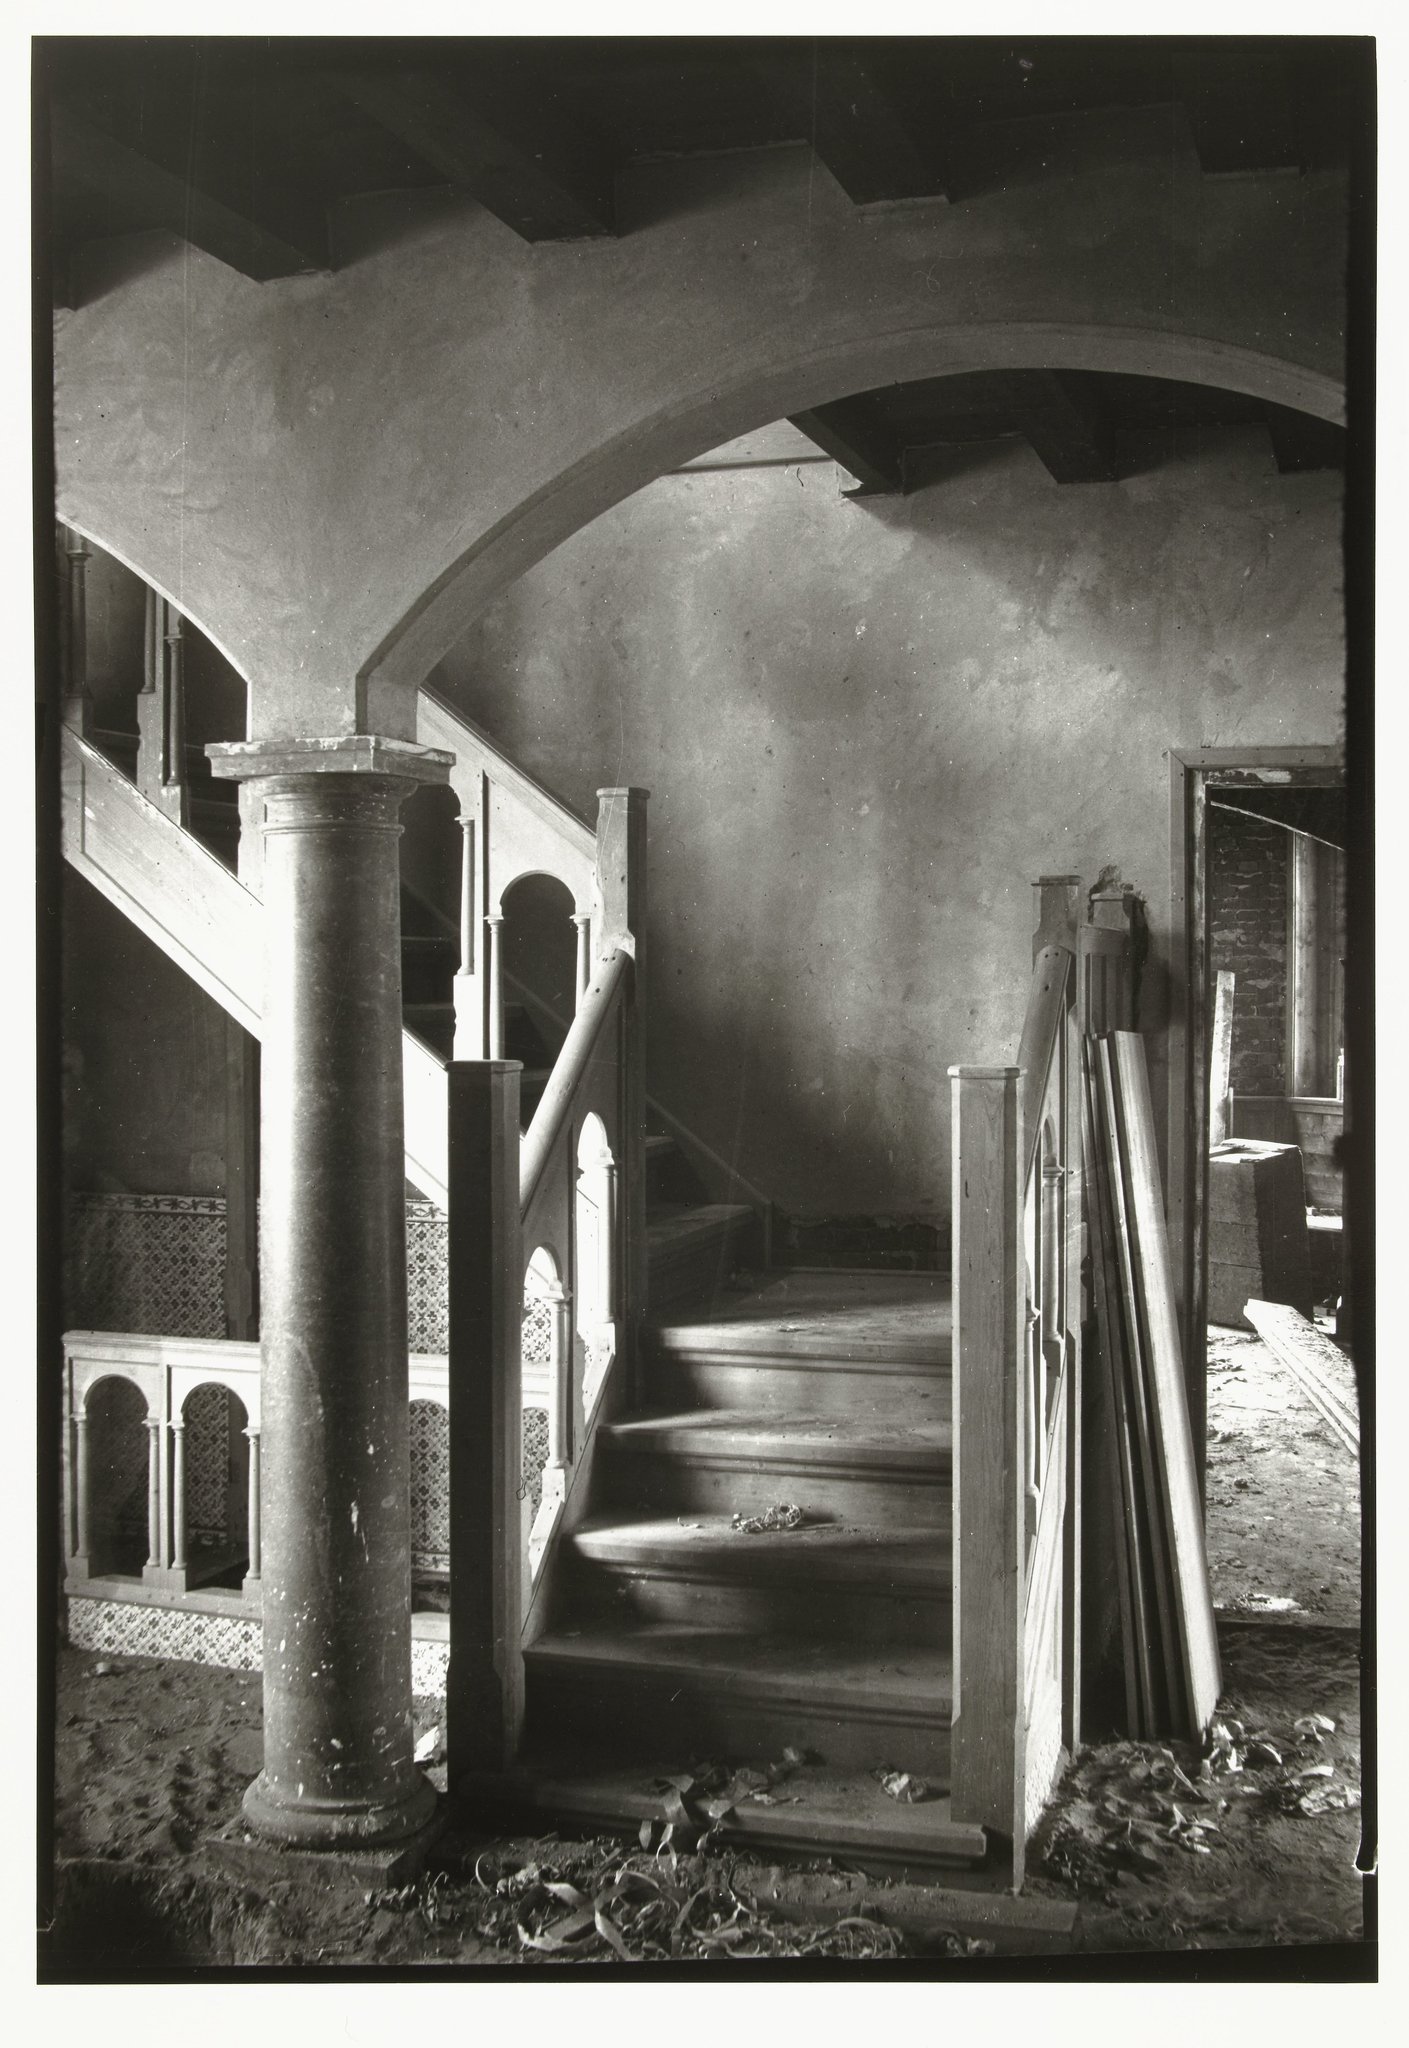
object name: photograph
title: De hal van huize Inter Quercus in Aerdenhout, in aanbouw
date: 1902-1910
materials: paper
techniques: gelatin silver print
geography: netherlands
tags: aerdenhout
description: Moderne afdruk van negatief BR 945 (collectie RKD).